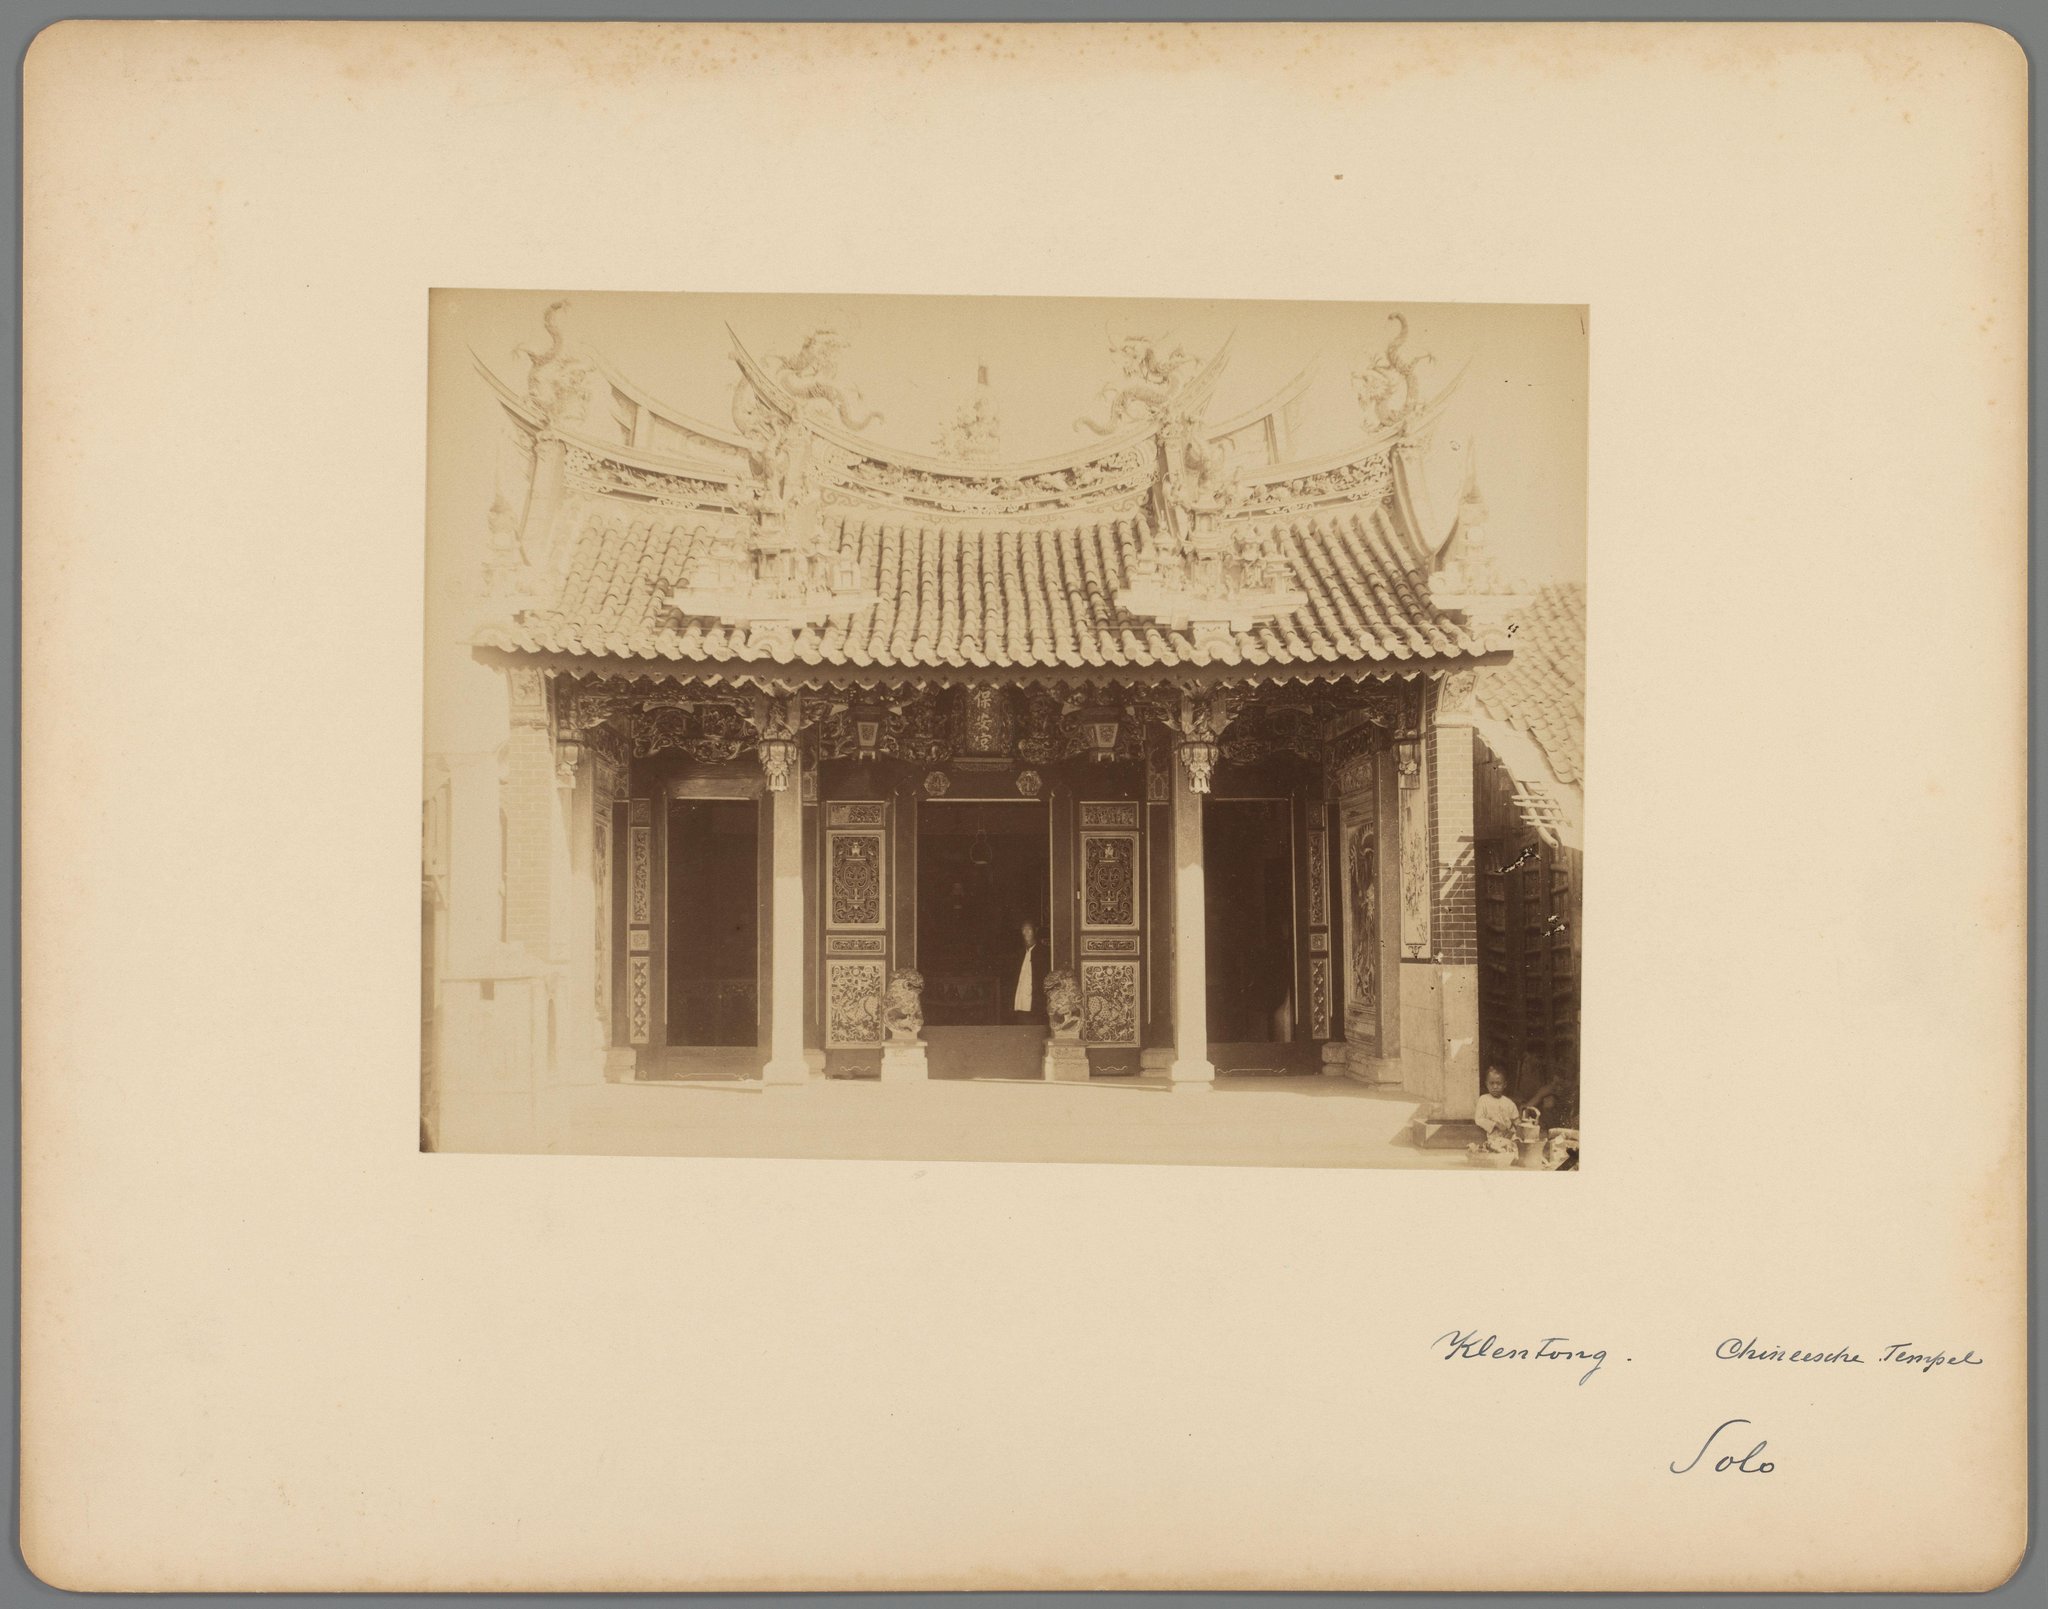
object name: photograph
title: Klentong. Chineesche Tempel. Solo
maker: Anonymous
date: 1851-1900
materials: cardboard, paper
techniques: albumen print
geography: surakarta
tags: temple, shrine ~ traditional chinese religions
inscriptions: inscription: ‘FOTO’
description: Deze foto zat oorspronkelijk in prentenkabinet RP-F-AA3192.